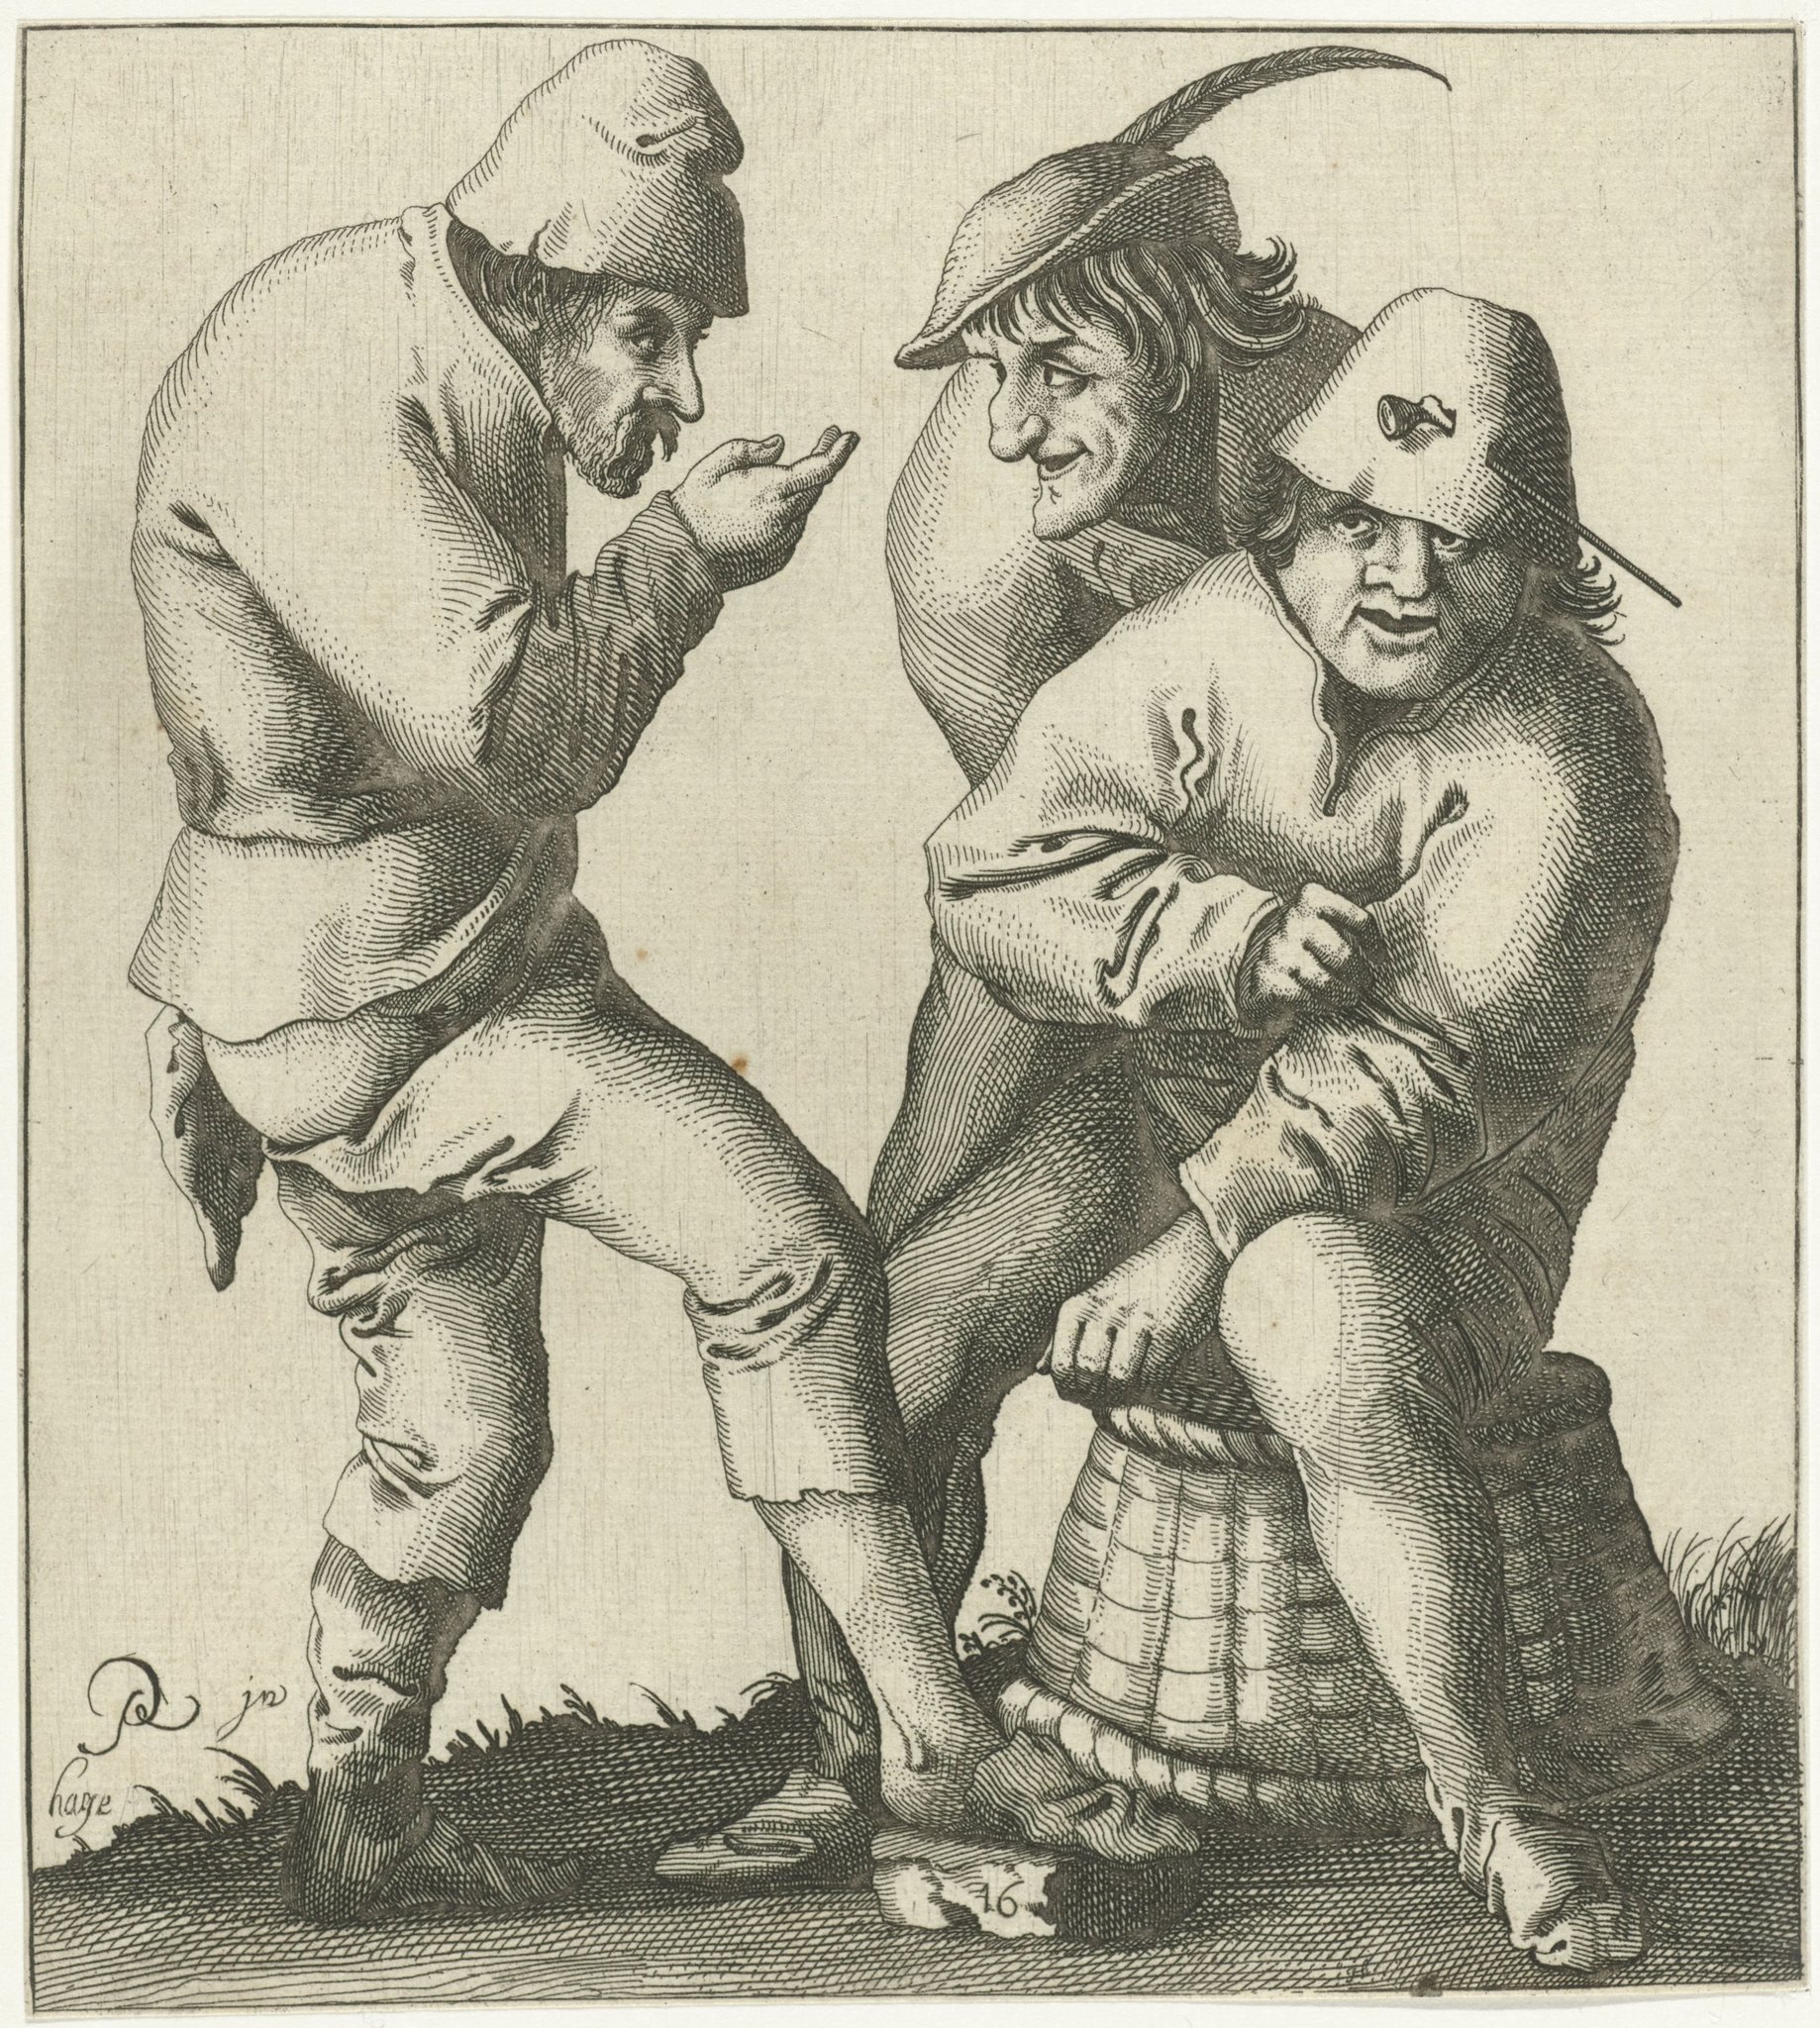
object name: print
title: Drie boeren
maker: pieter jansz quast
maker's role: draughtsman, painter, print maker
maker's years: 1605-1647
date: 1634-1638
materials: paper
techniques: engraving, etching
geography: the hague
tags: pipe ~ tobacco, farmers, head-gear: hat (+ men's clothes), container made of plant material other than wood: basket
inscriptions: collector's mark: Lugt 2228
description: Een boer met een muts op het hoofd, waar een pijp doorheen is gestoken, zit op een omgekeerde mand. Bij hem twee staande boeren. De prent maakt deel uit van een serie van zesentwintig prenten met bedelaars en boeren.